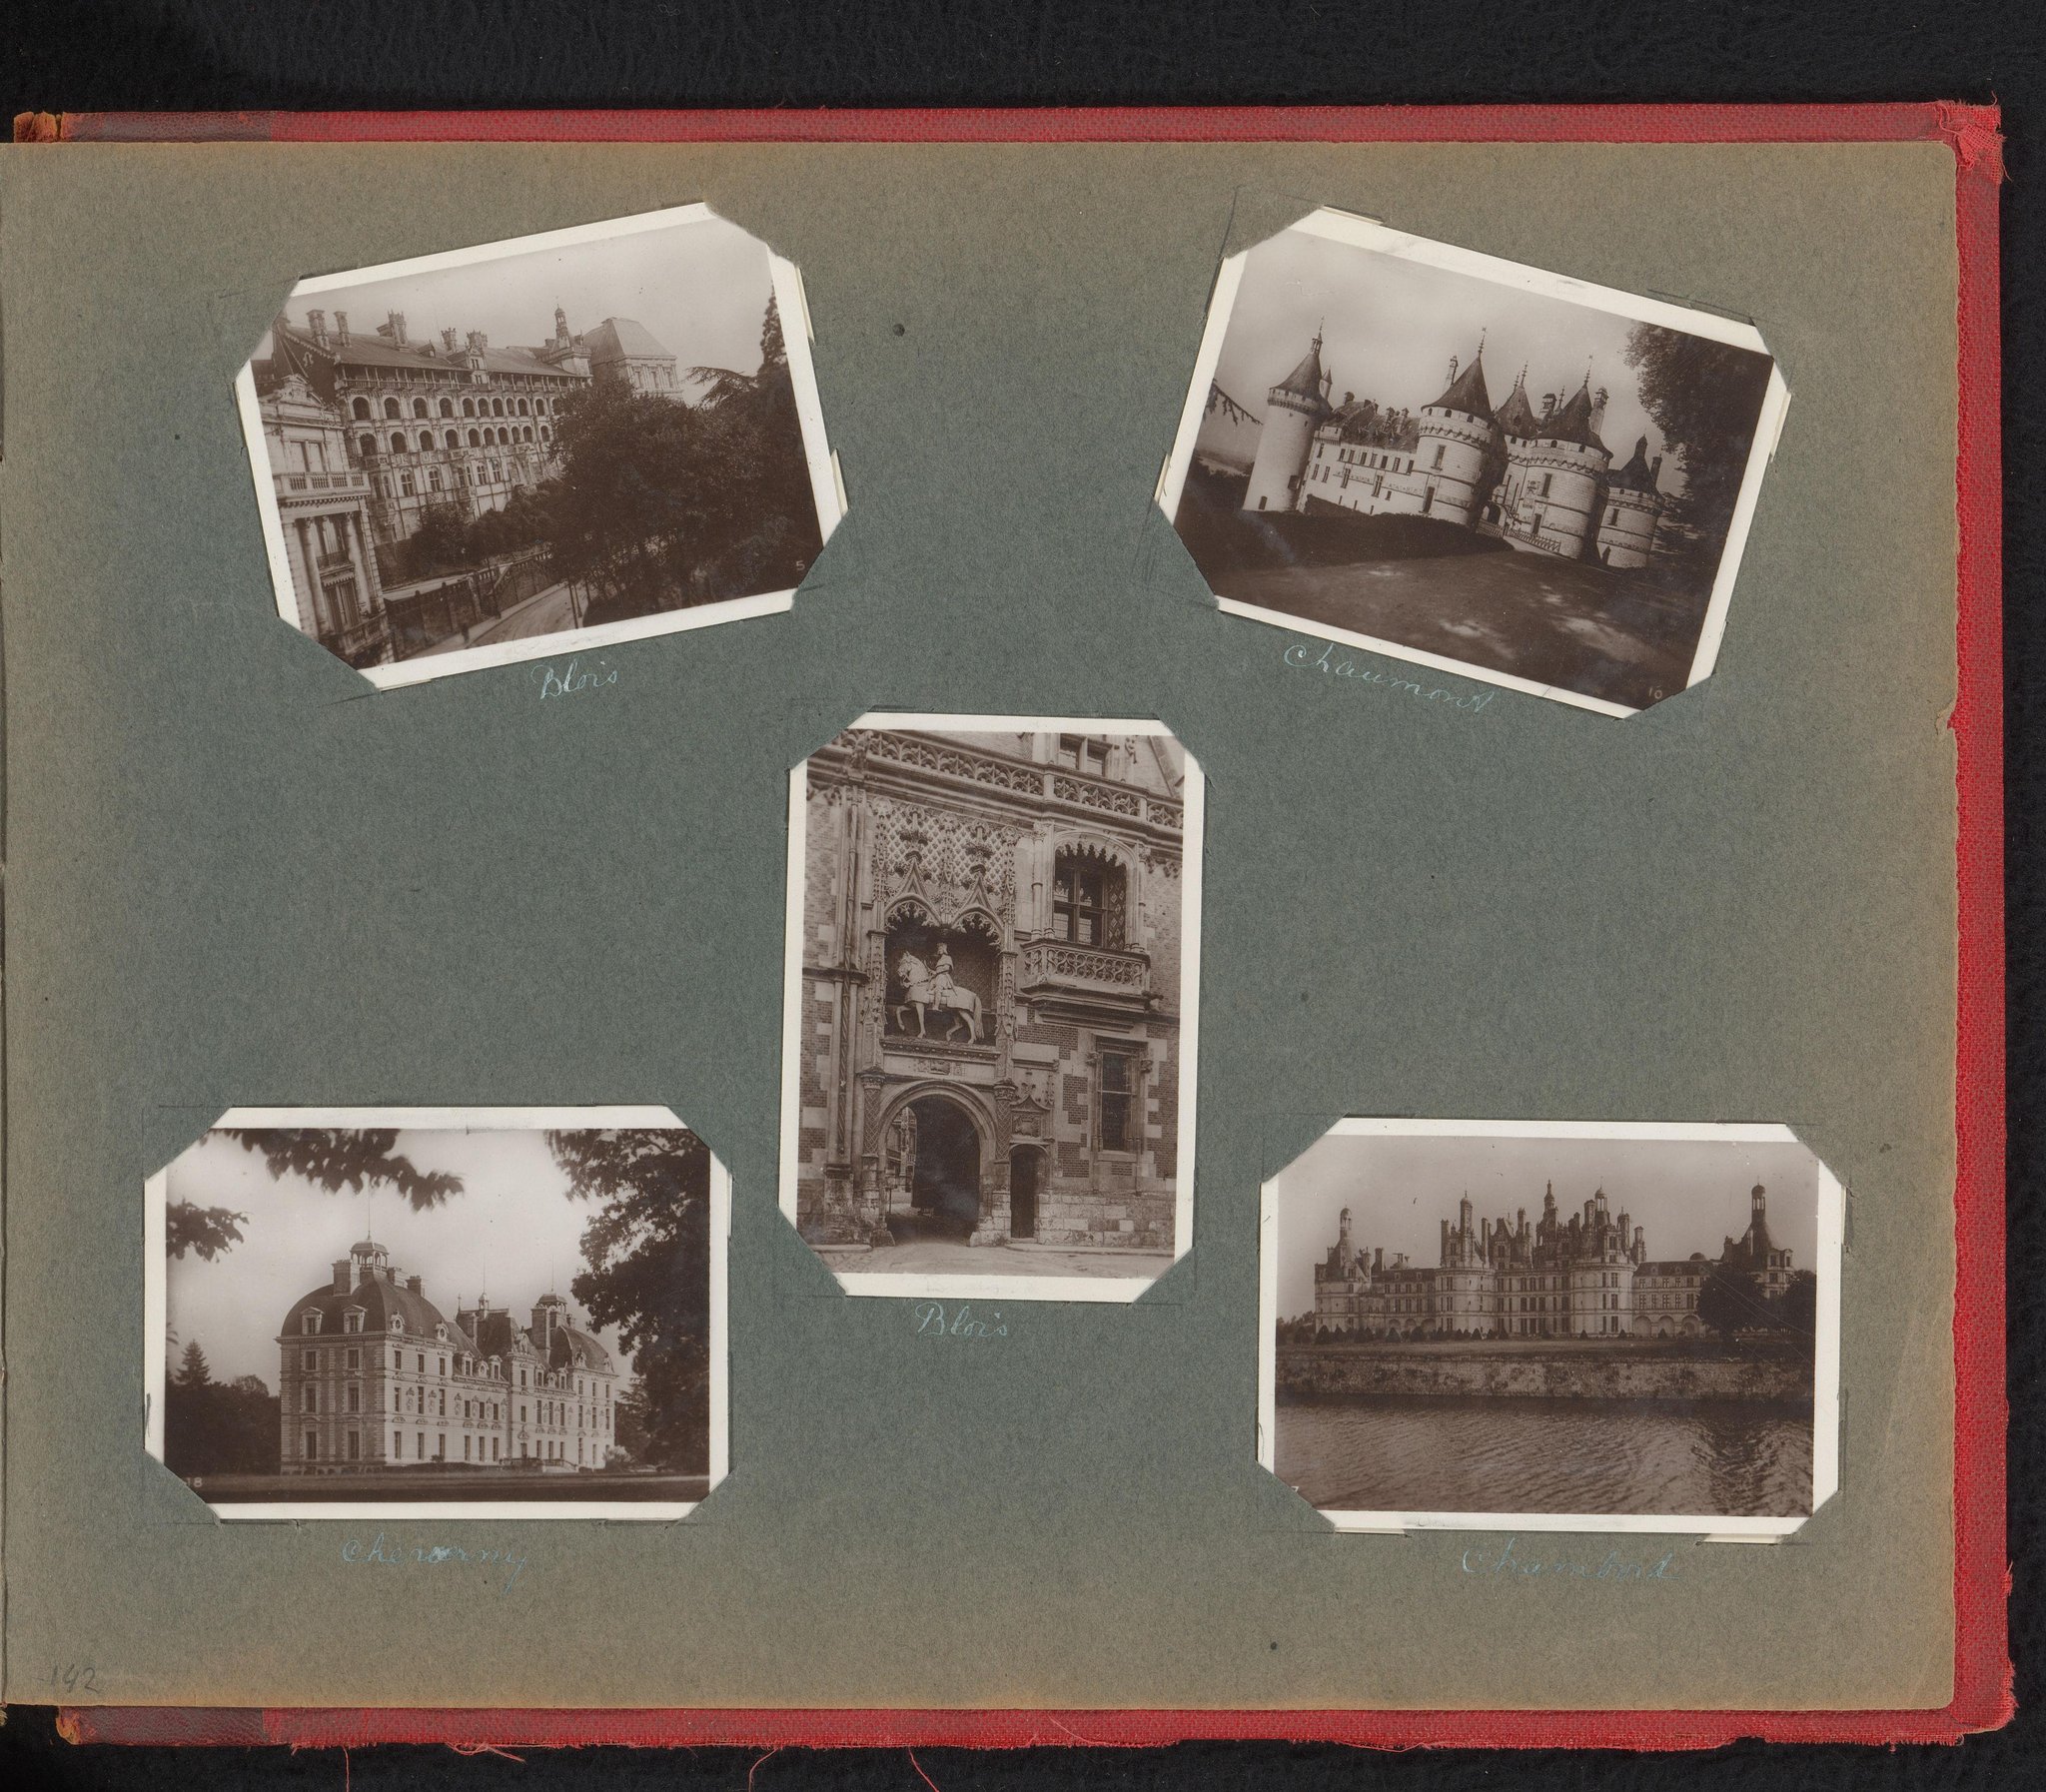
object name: photograph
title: Gezichten op de kastelen van Blois, Chaumont, Chambord en Cheverny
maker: Anonymous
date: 1905-1926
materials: paper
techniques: gelatin silver print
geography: france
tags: castle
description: Groot Plattenberg was eigendom van Jacob Theodorus (Co) Boelen.